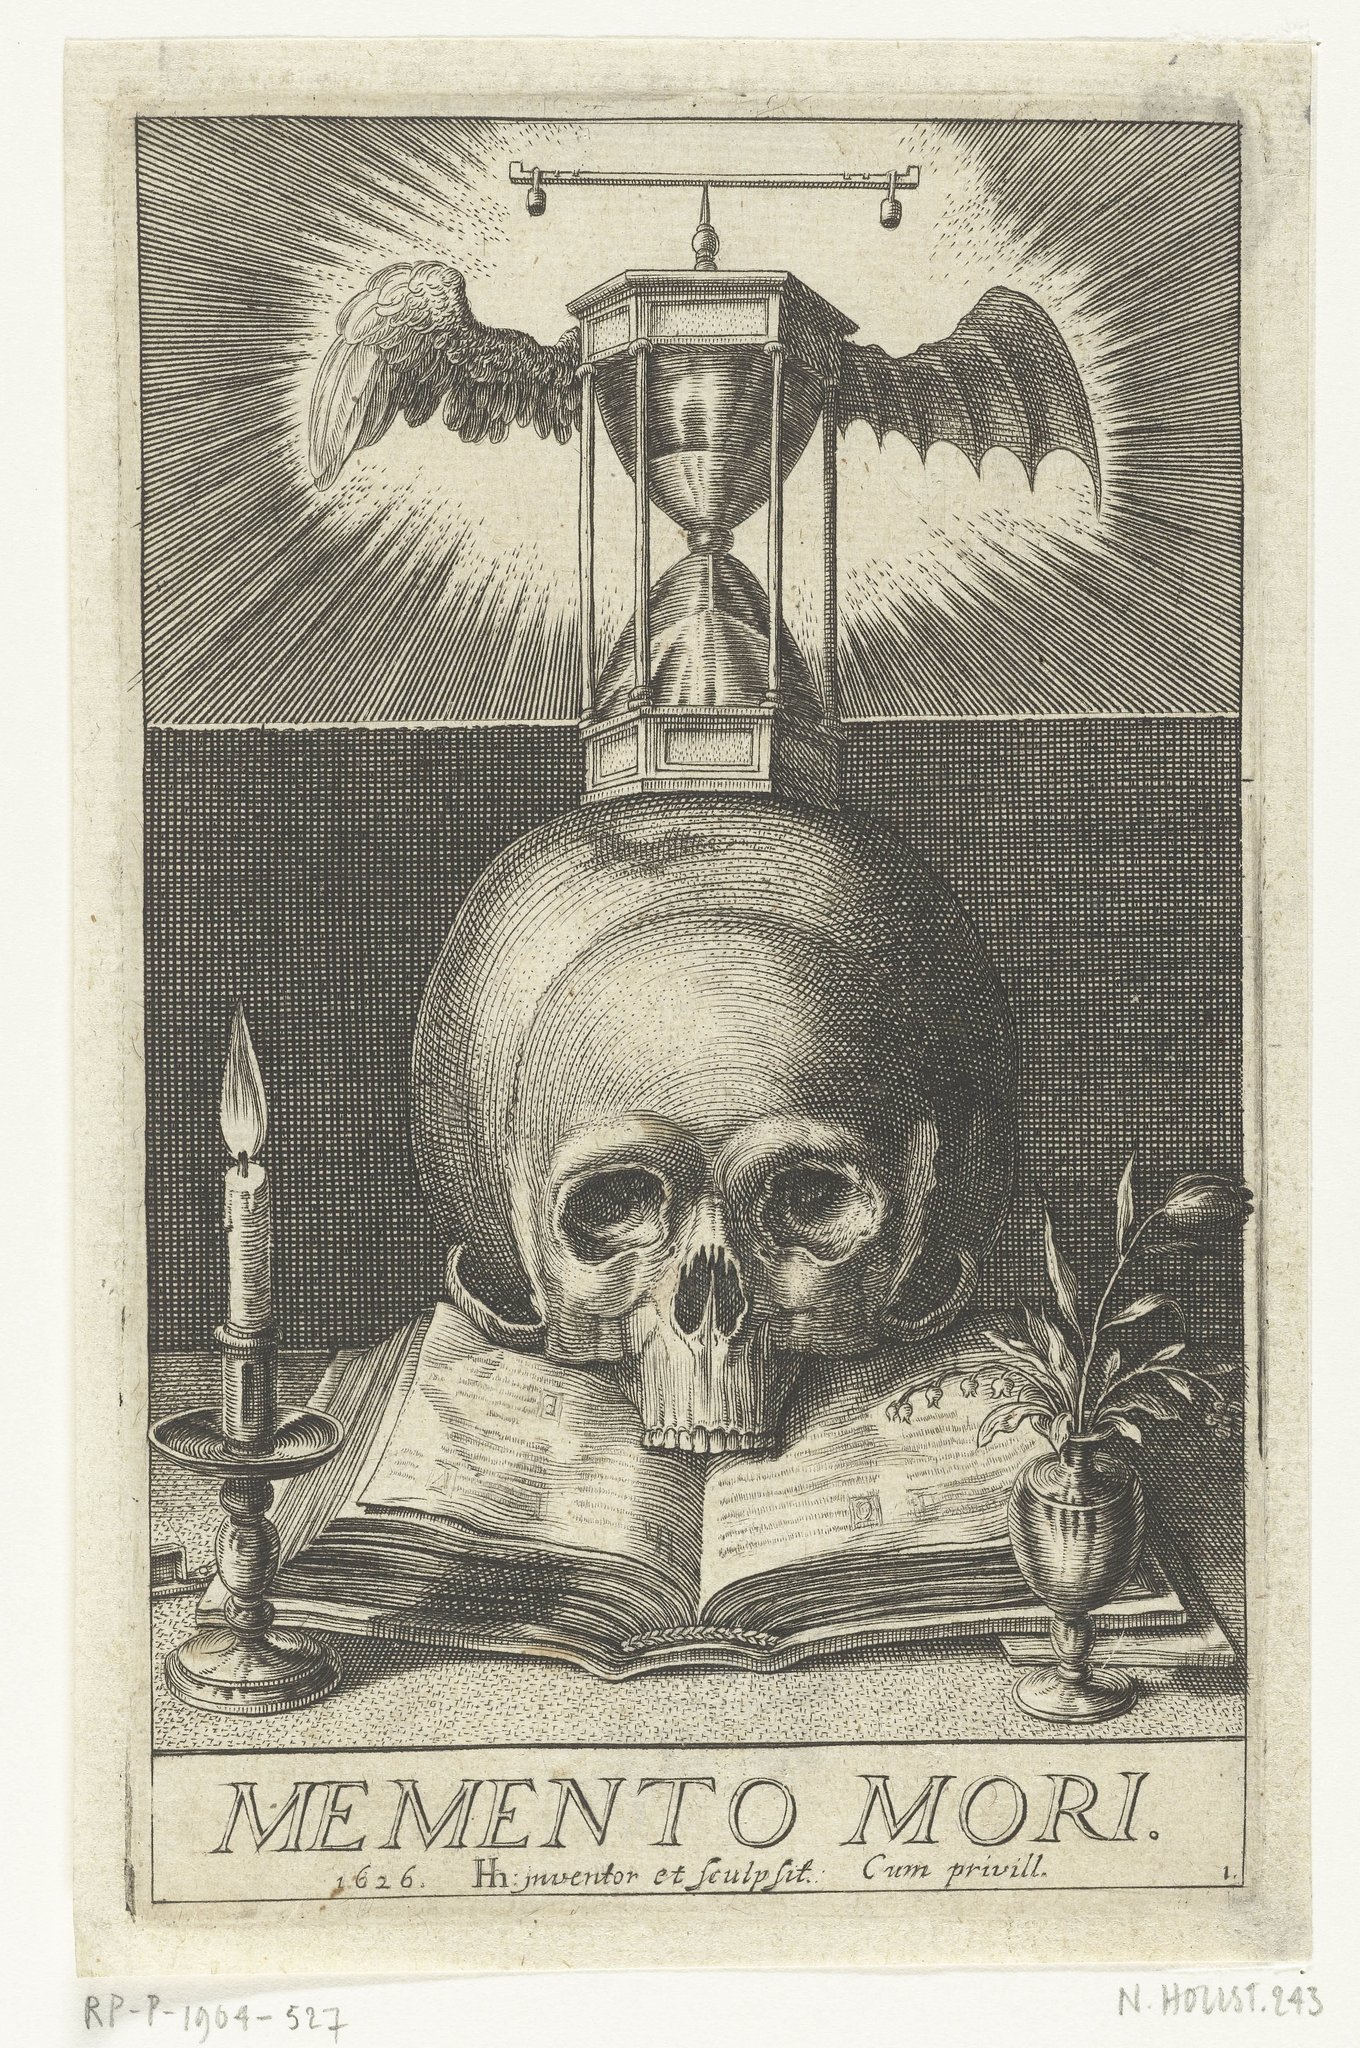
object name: titelprent, frontispice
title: Dierskeletten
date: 1626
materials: paper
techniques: engraving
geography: the hague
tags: title-page, scales, skull as symbol of 'vanitas', hourglass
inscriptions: title: ‘MEMENTO MORI’, monogram: ‘Hh’, collector's mark: Lugt 2228, privilege: ‘Cum privil.’, signature and date: ‘1626 Hh inventor et sculpsit.’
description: Een doodshoofd op opengeslagen boek tussen een bloem in vaas en een brandende kaars. Op het doodshoofd een gevleugelde zandloper met balans. Onderaan de titel. Eerste prent uit een serie van 23 prenten met dierskeletten, waarvan er vijftien zijn vervaardigd door Hendrick Hondius I en de andere door Andries Jacobsz. Stock en Simon Frisius.